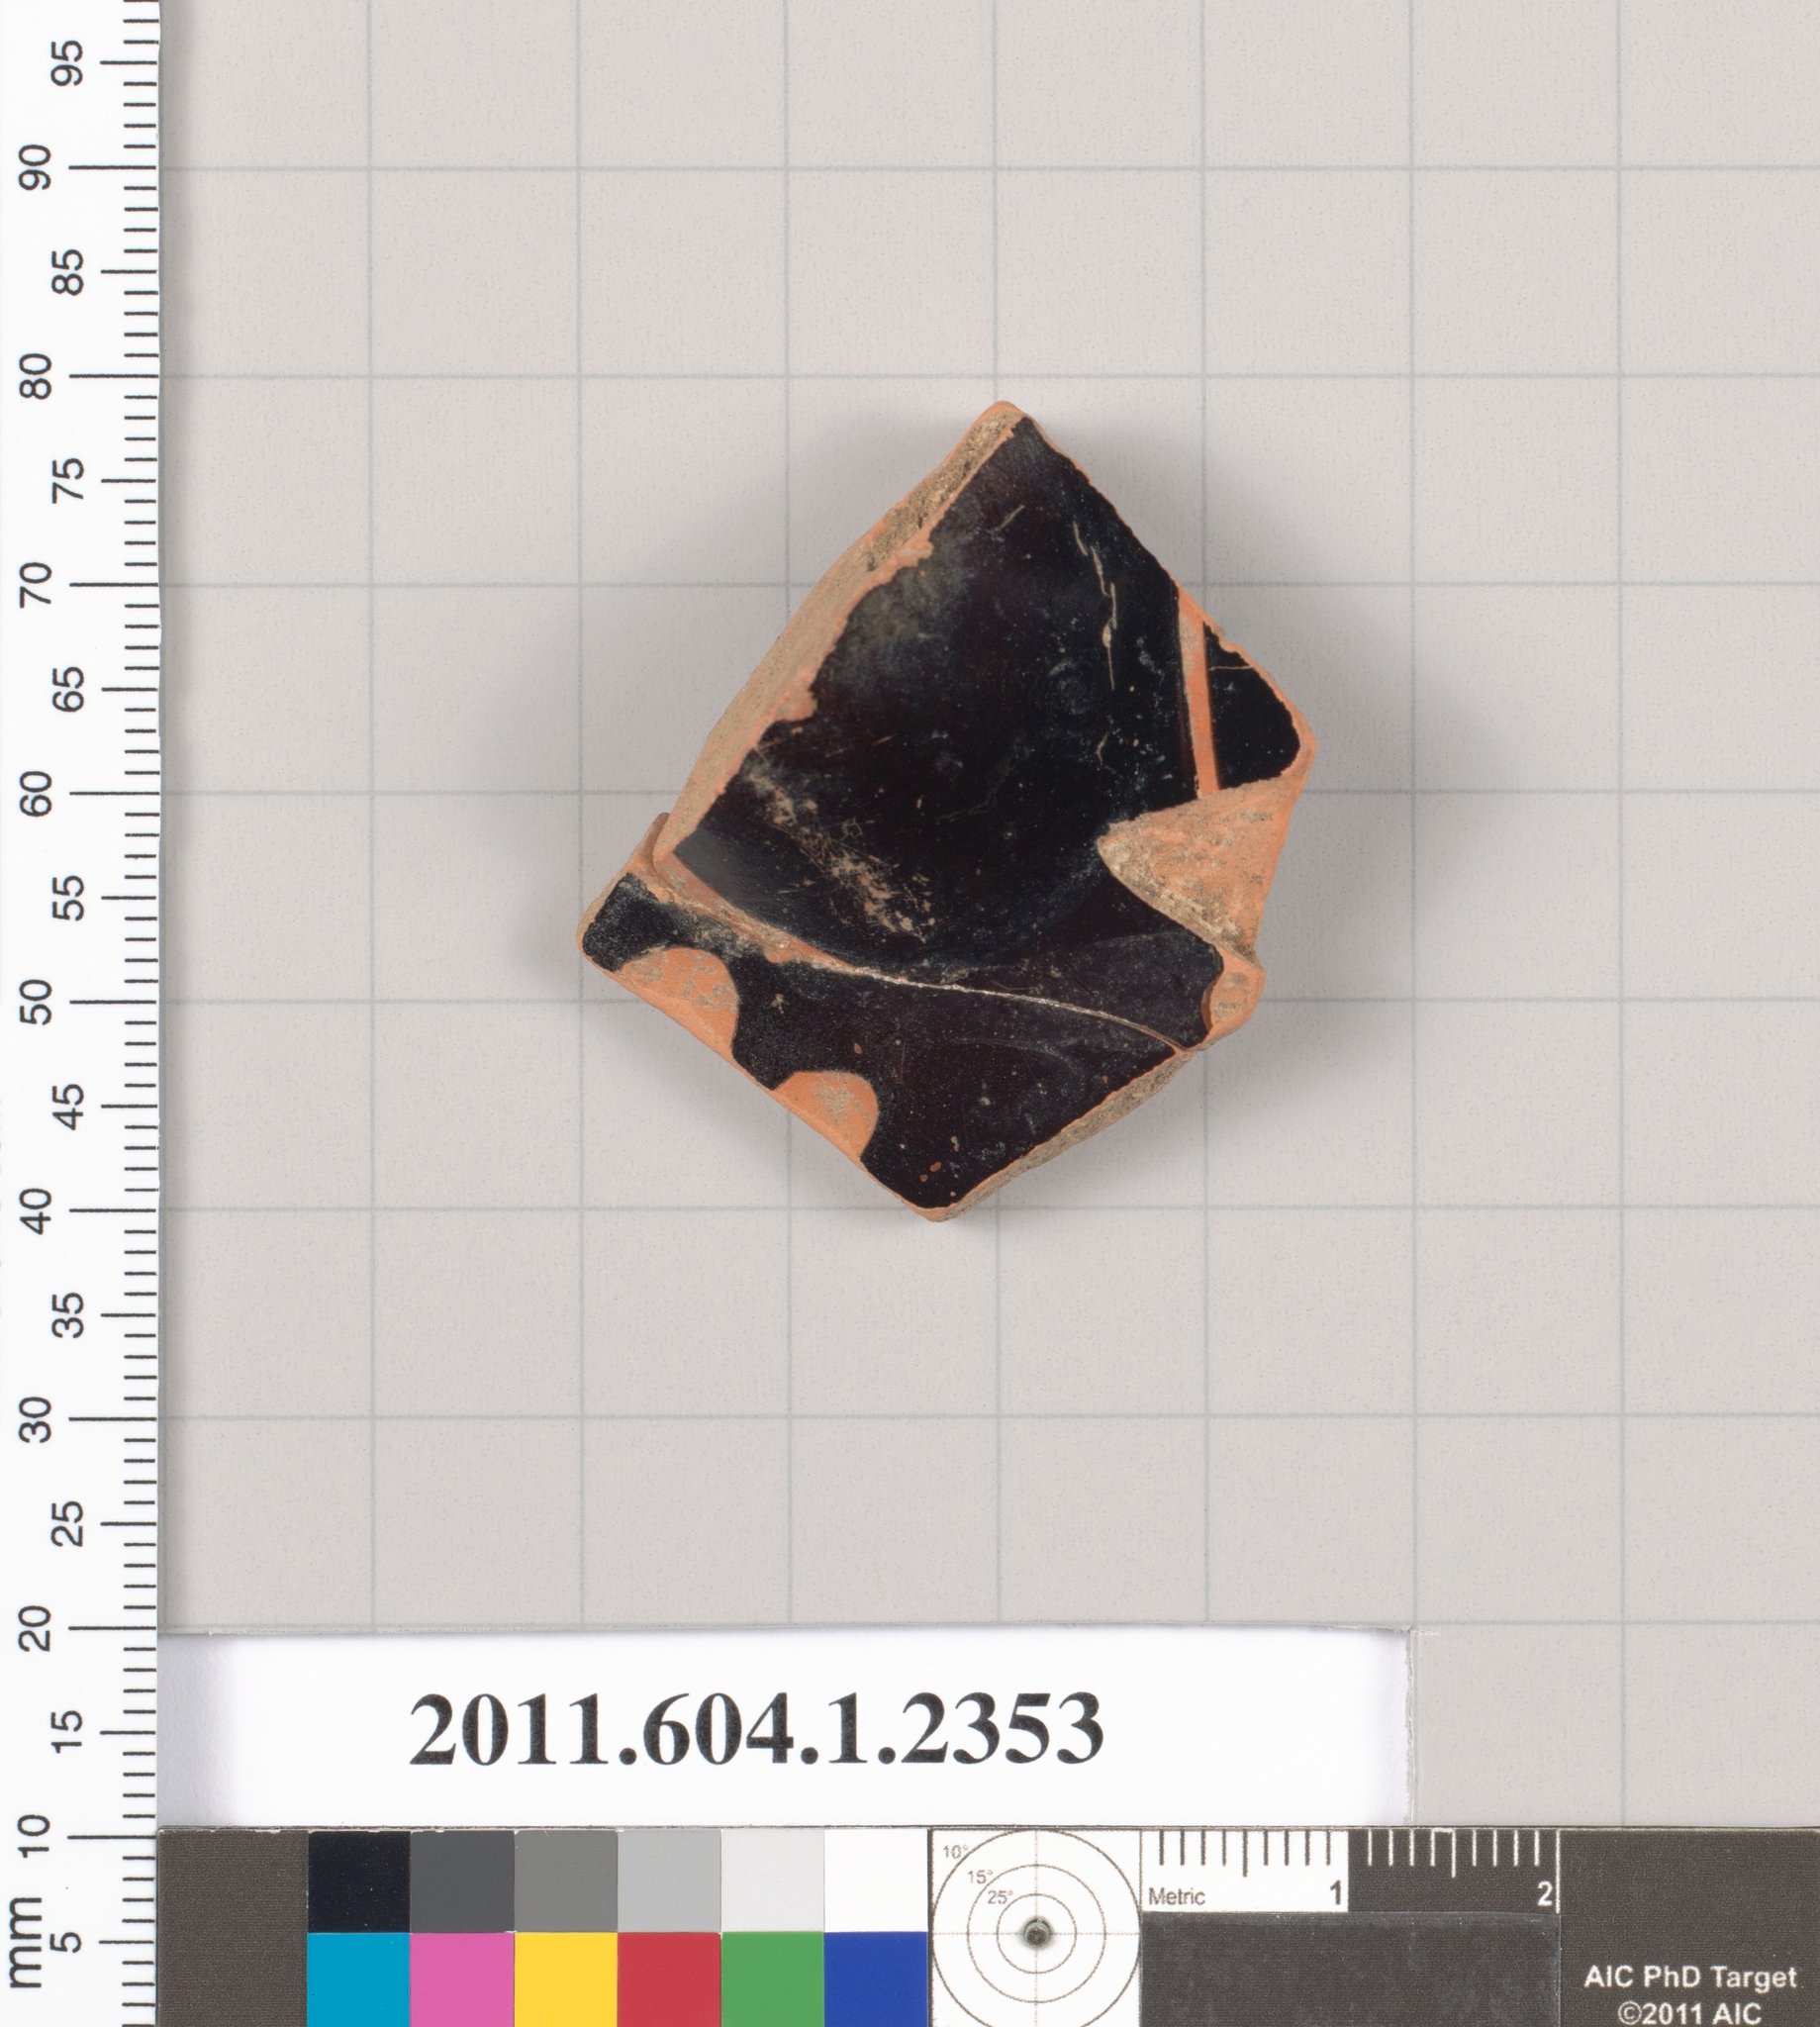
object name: kylix fragment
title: Terracotta fragment of a kylix (drinking cup)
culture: greek, attic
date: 475-451 BCE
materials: terracotta